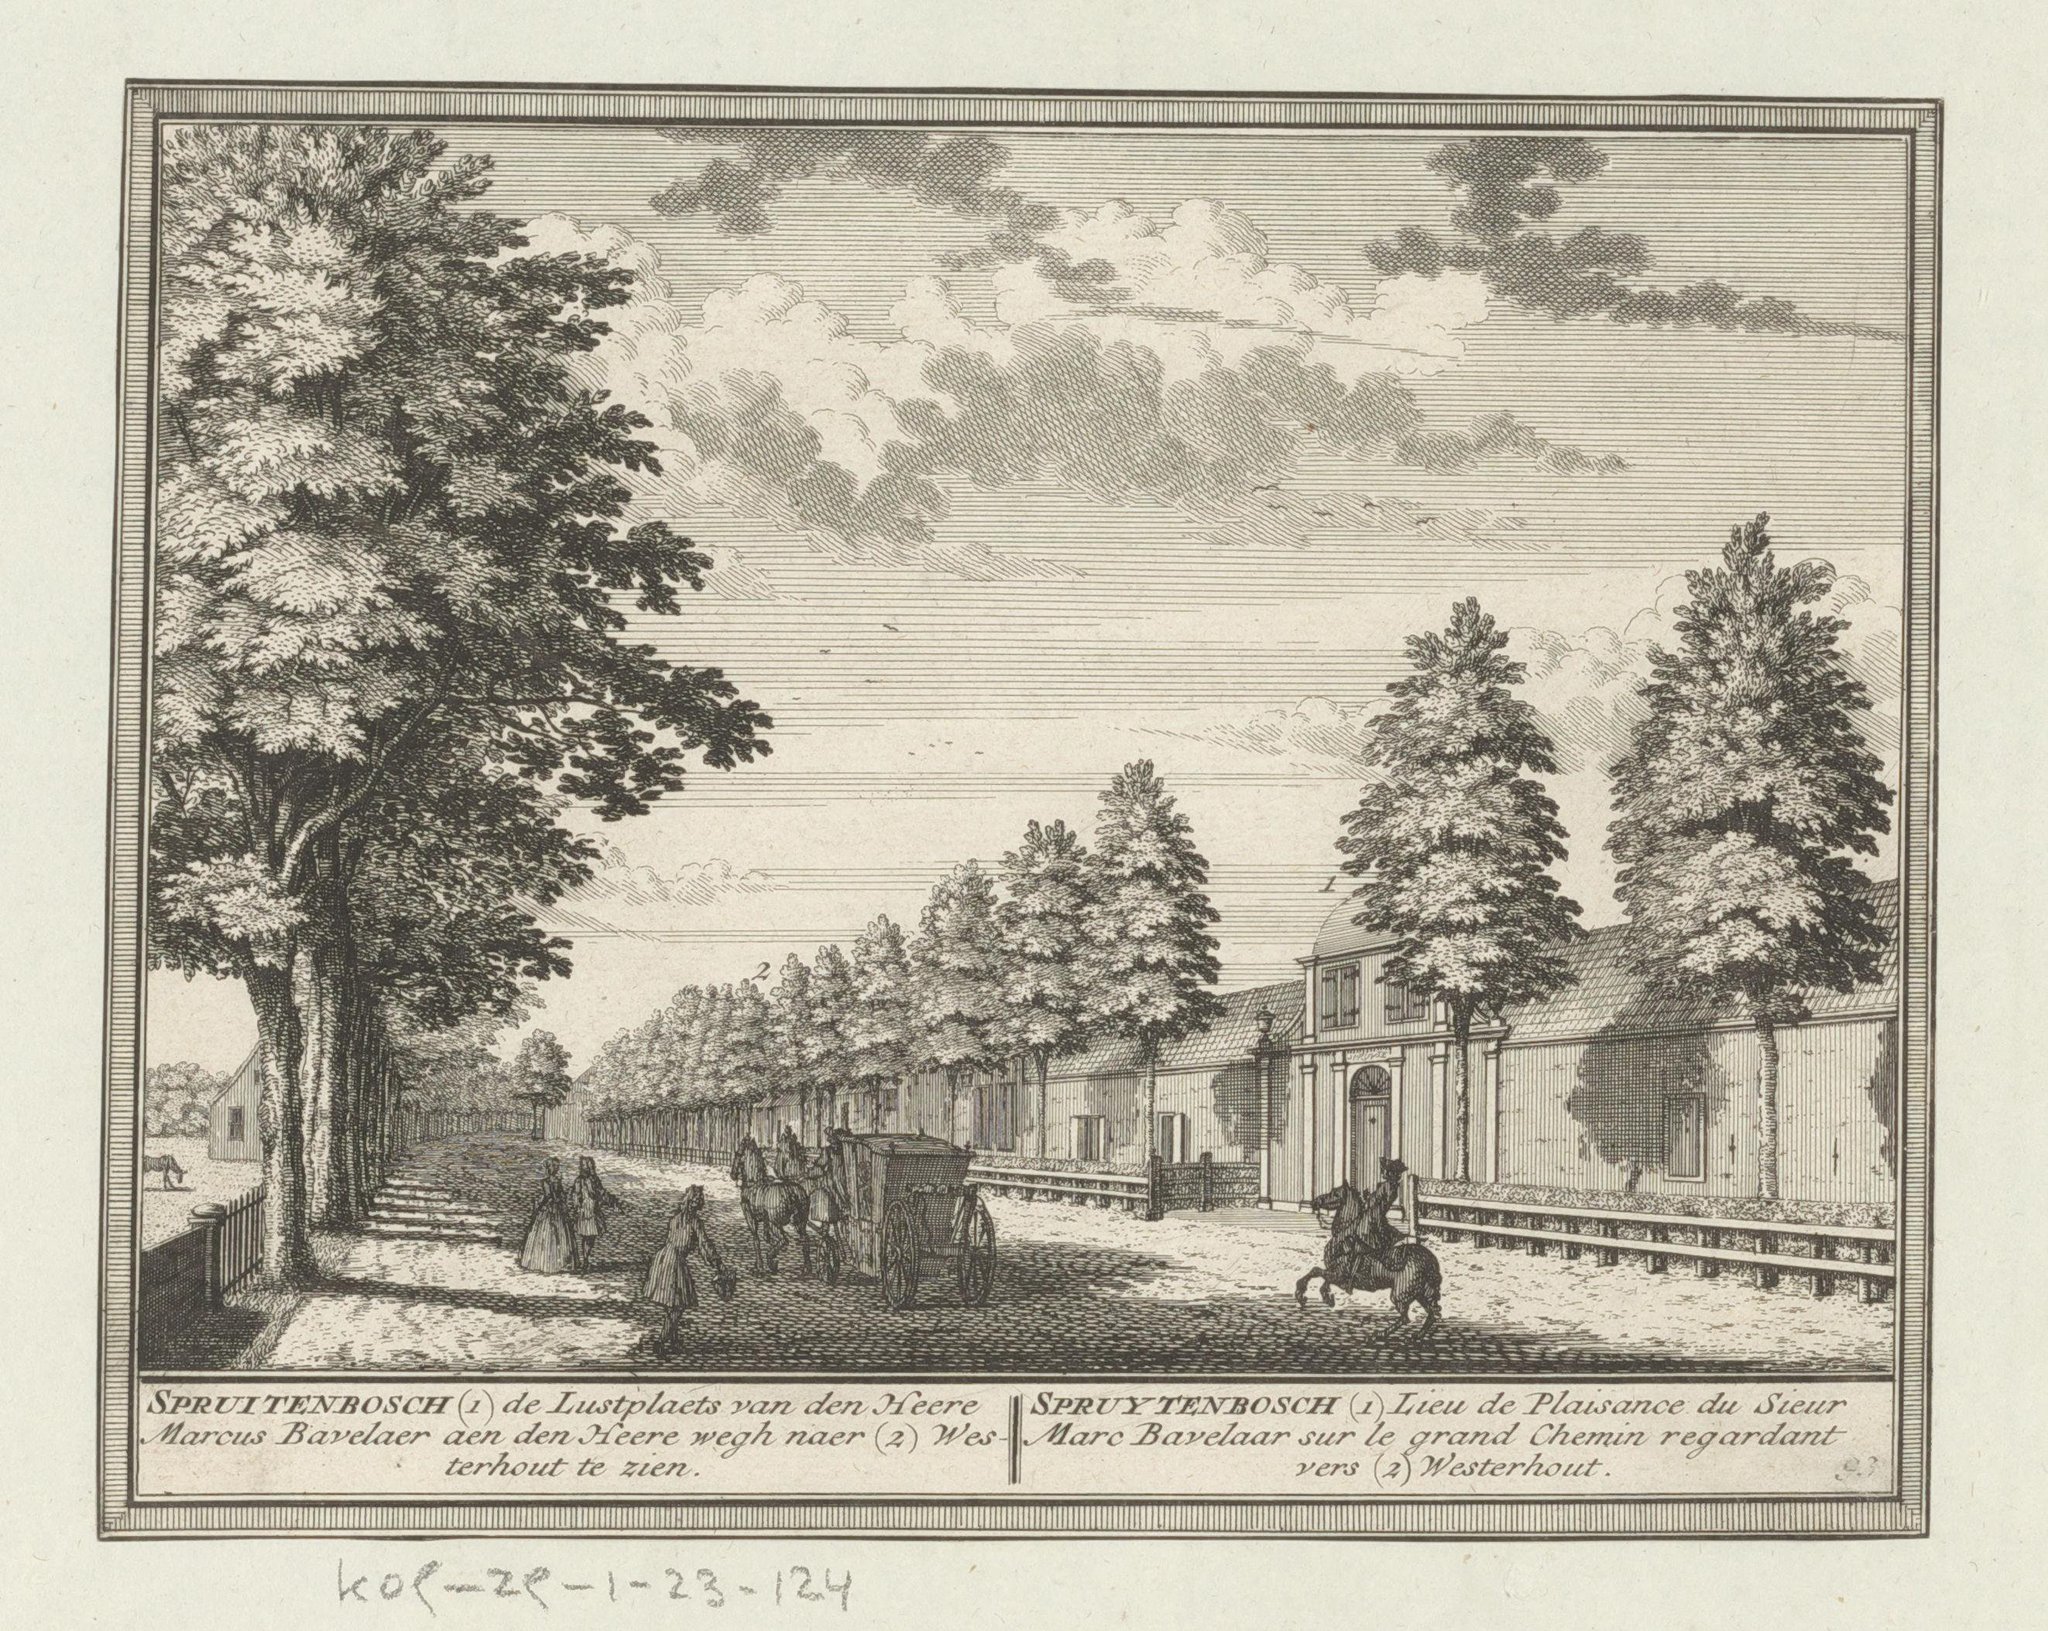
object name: print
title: Gezicht op buitenplaats Spruit en Bosch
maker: hendrik de leth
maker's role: draughtsman, print maker, publisher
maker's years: 1703-1766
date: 1732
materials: paper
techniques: engraving, etching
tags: four-wheeled, animal-drawn vehicle, e.g.: cab, carriage, coach, lane, alley, country-house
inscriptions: collector's mark: Lugt 1641, stamp, stamp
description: Prent waarschijnlijk uit: Broüerius van Nidek, Mattheus. Het Zegenpralent Kennemerlant, vertoont in veele Heerlijke Gezichten. Amsterdam: Leth, Hendrik de en Leth, Andries de, 1732, dl. 2.